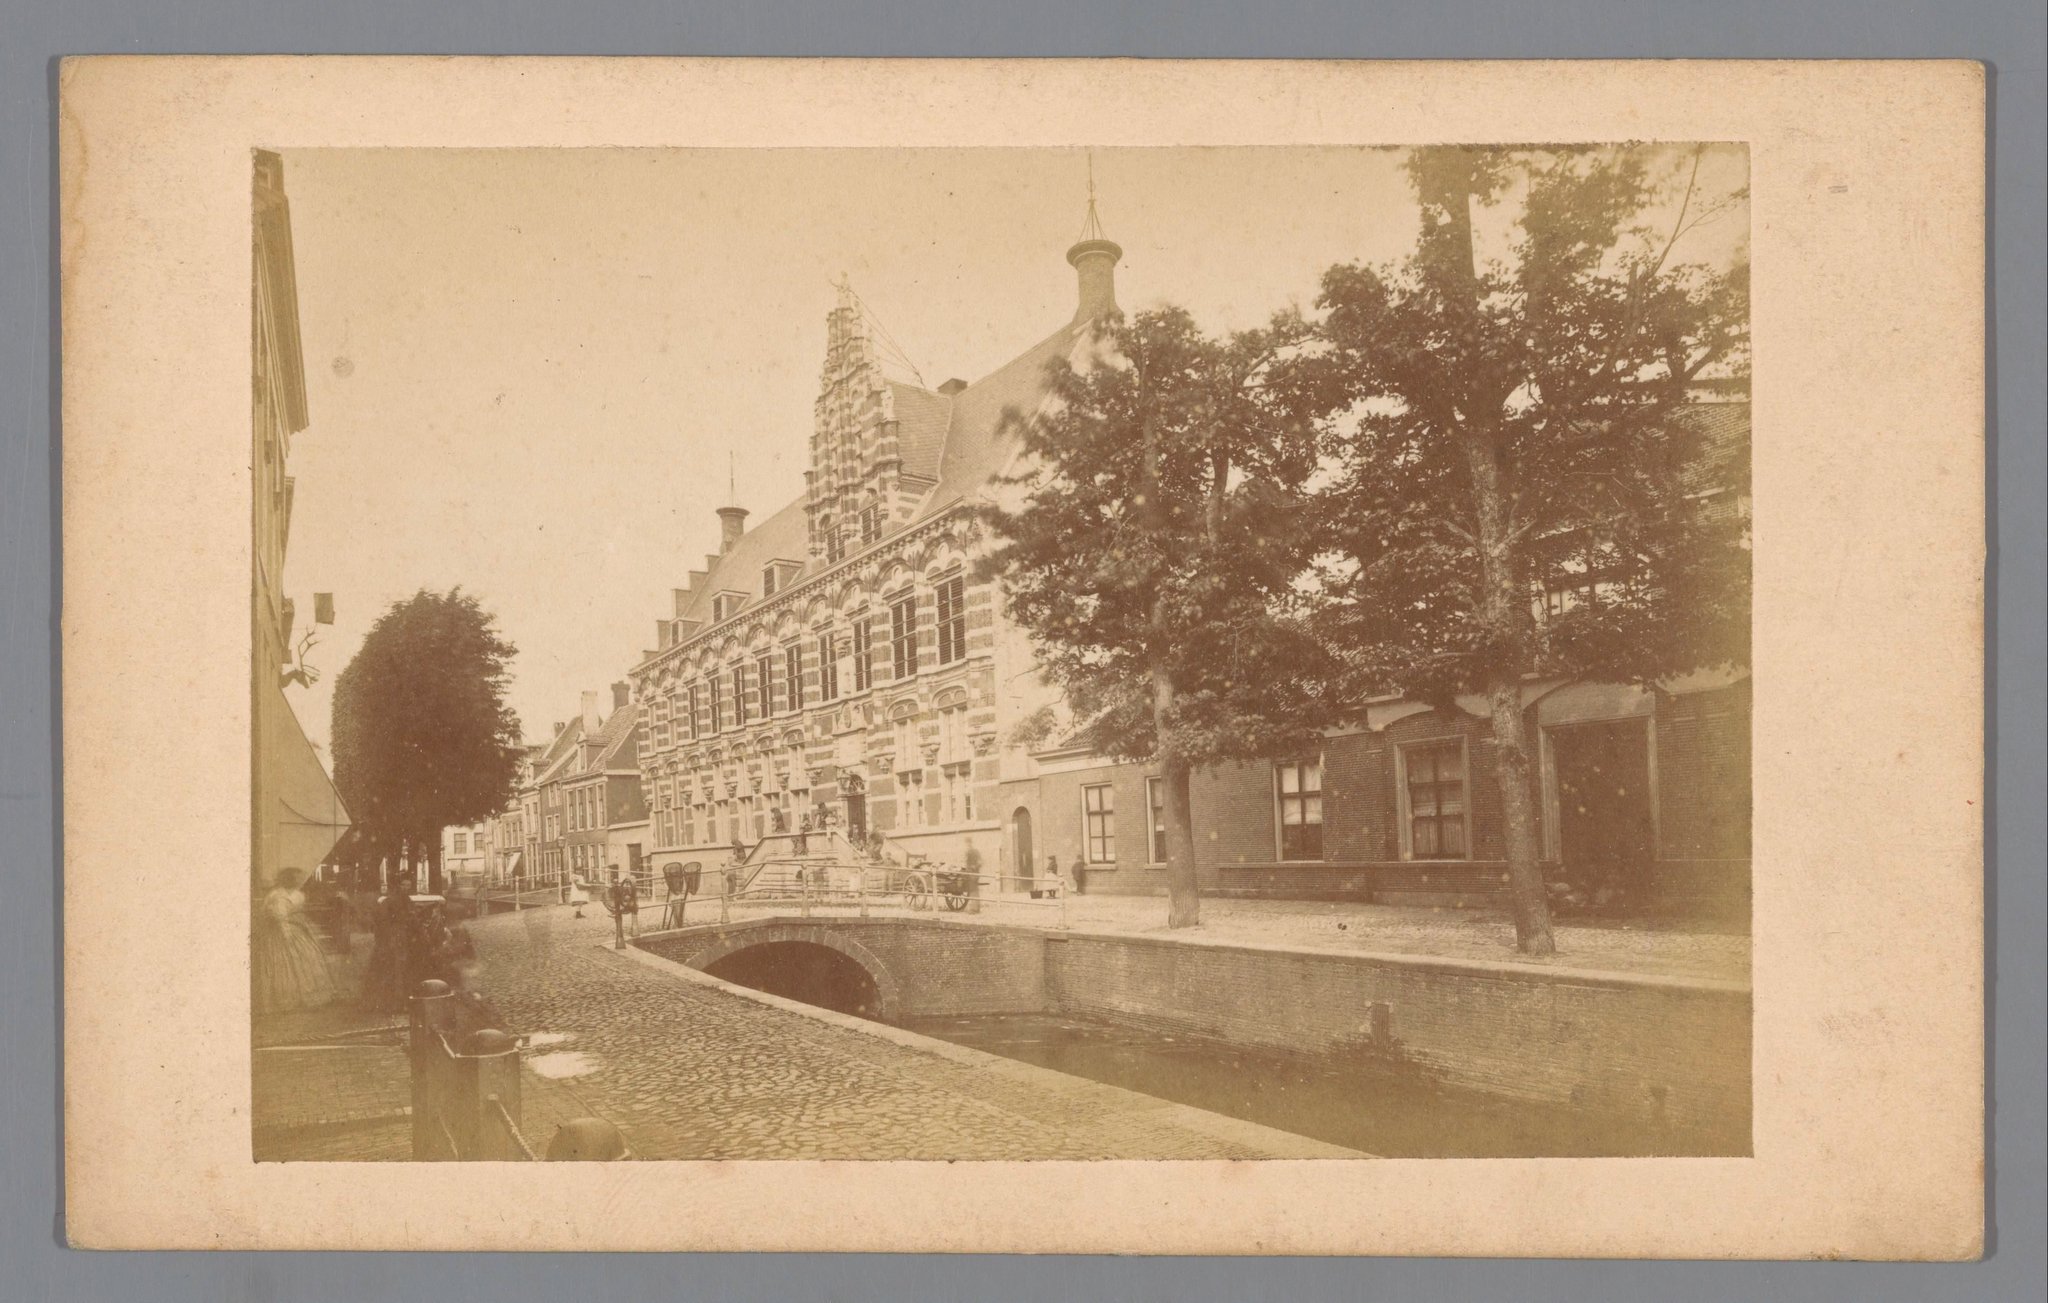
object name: photograph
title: Gezicht op de Kanselarij te Leeuwarden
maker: Anonymous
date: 1850-1900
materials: cardboard, photographic support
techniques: albumen print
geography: leeuwarden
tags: decorated gable, city-view in general; 'veduta'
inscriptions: inscription: ‘Leeuwarden/ Kanselarij’